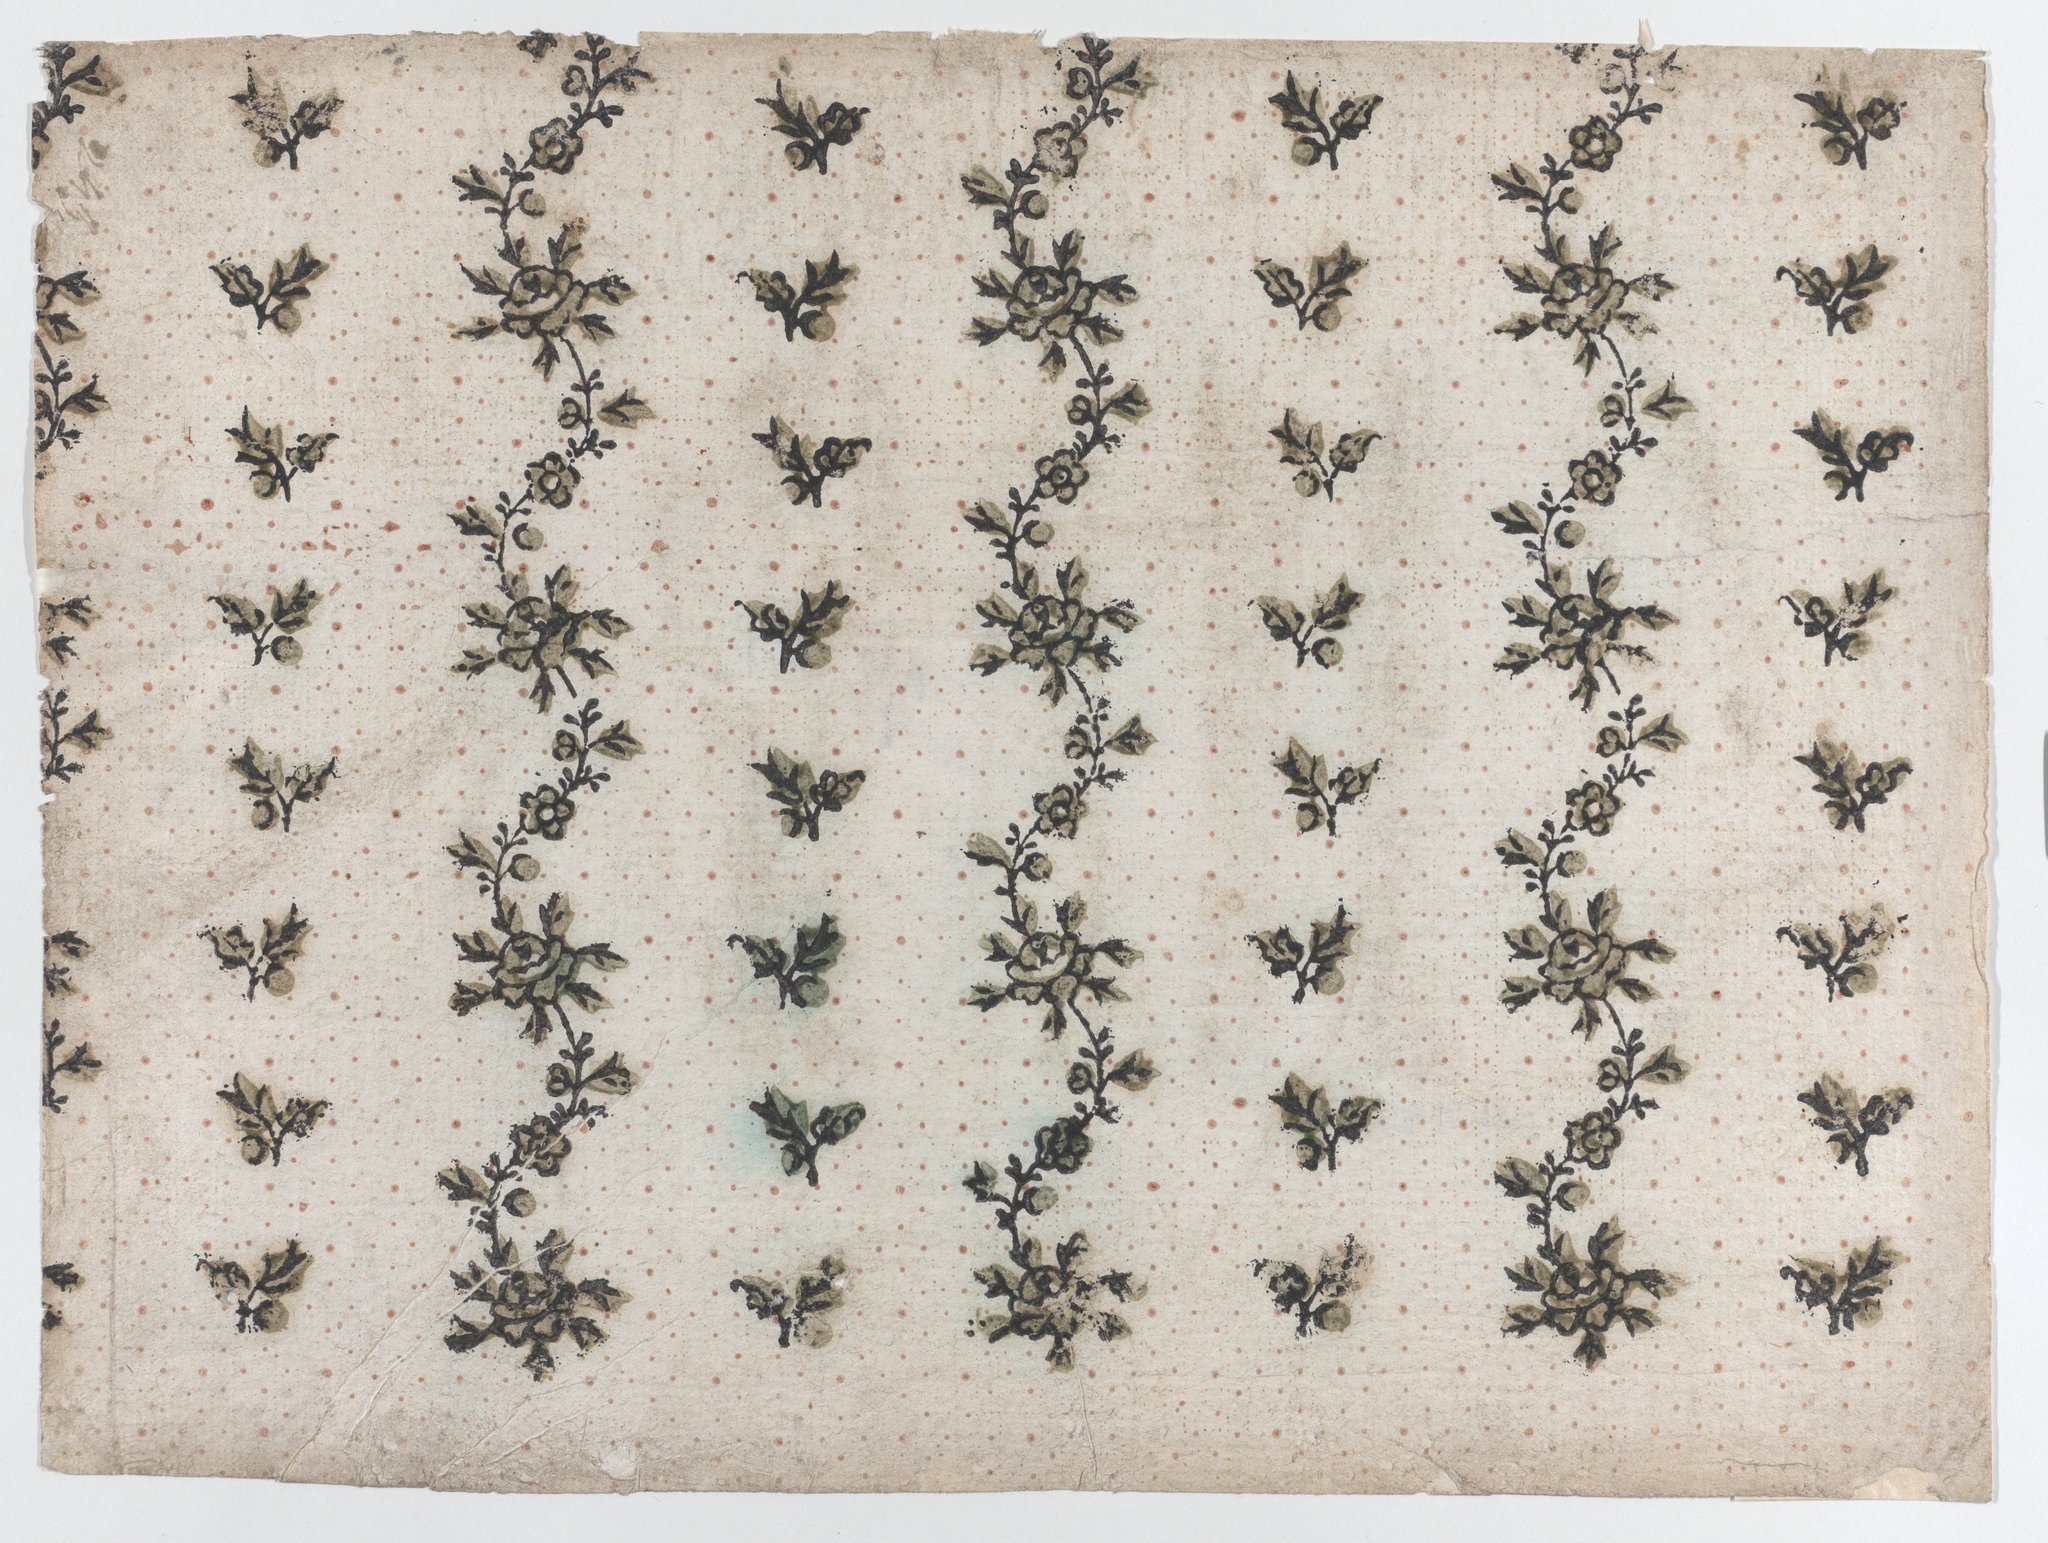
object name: print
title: Sheet with overall dot and floral pattern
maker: Anonymous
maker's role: artist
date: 1767-1866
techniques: relief print